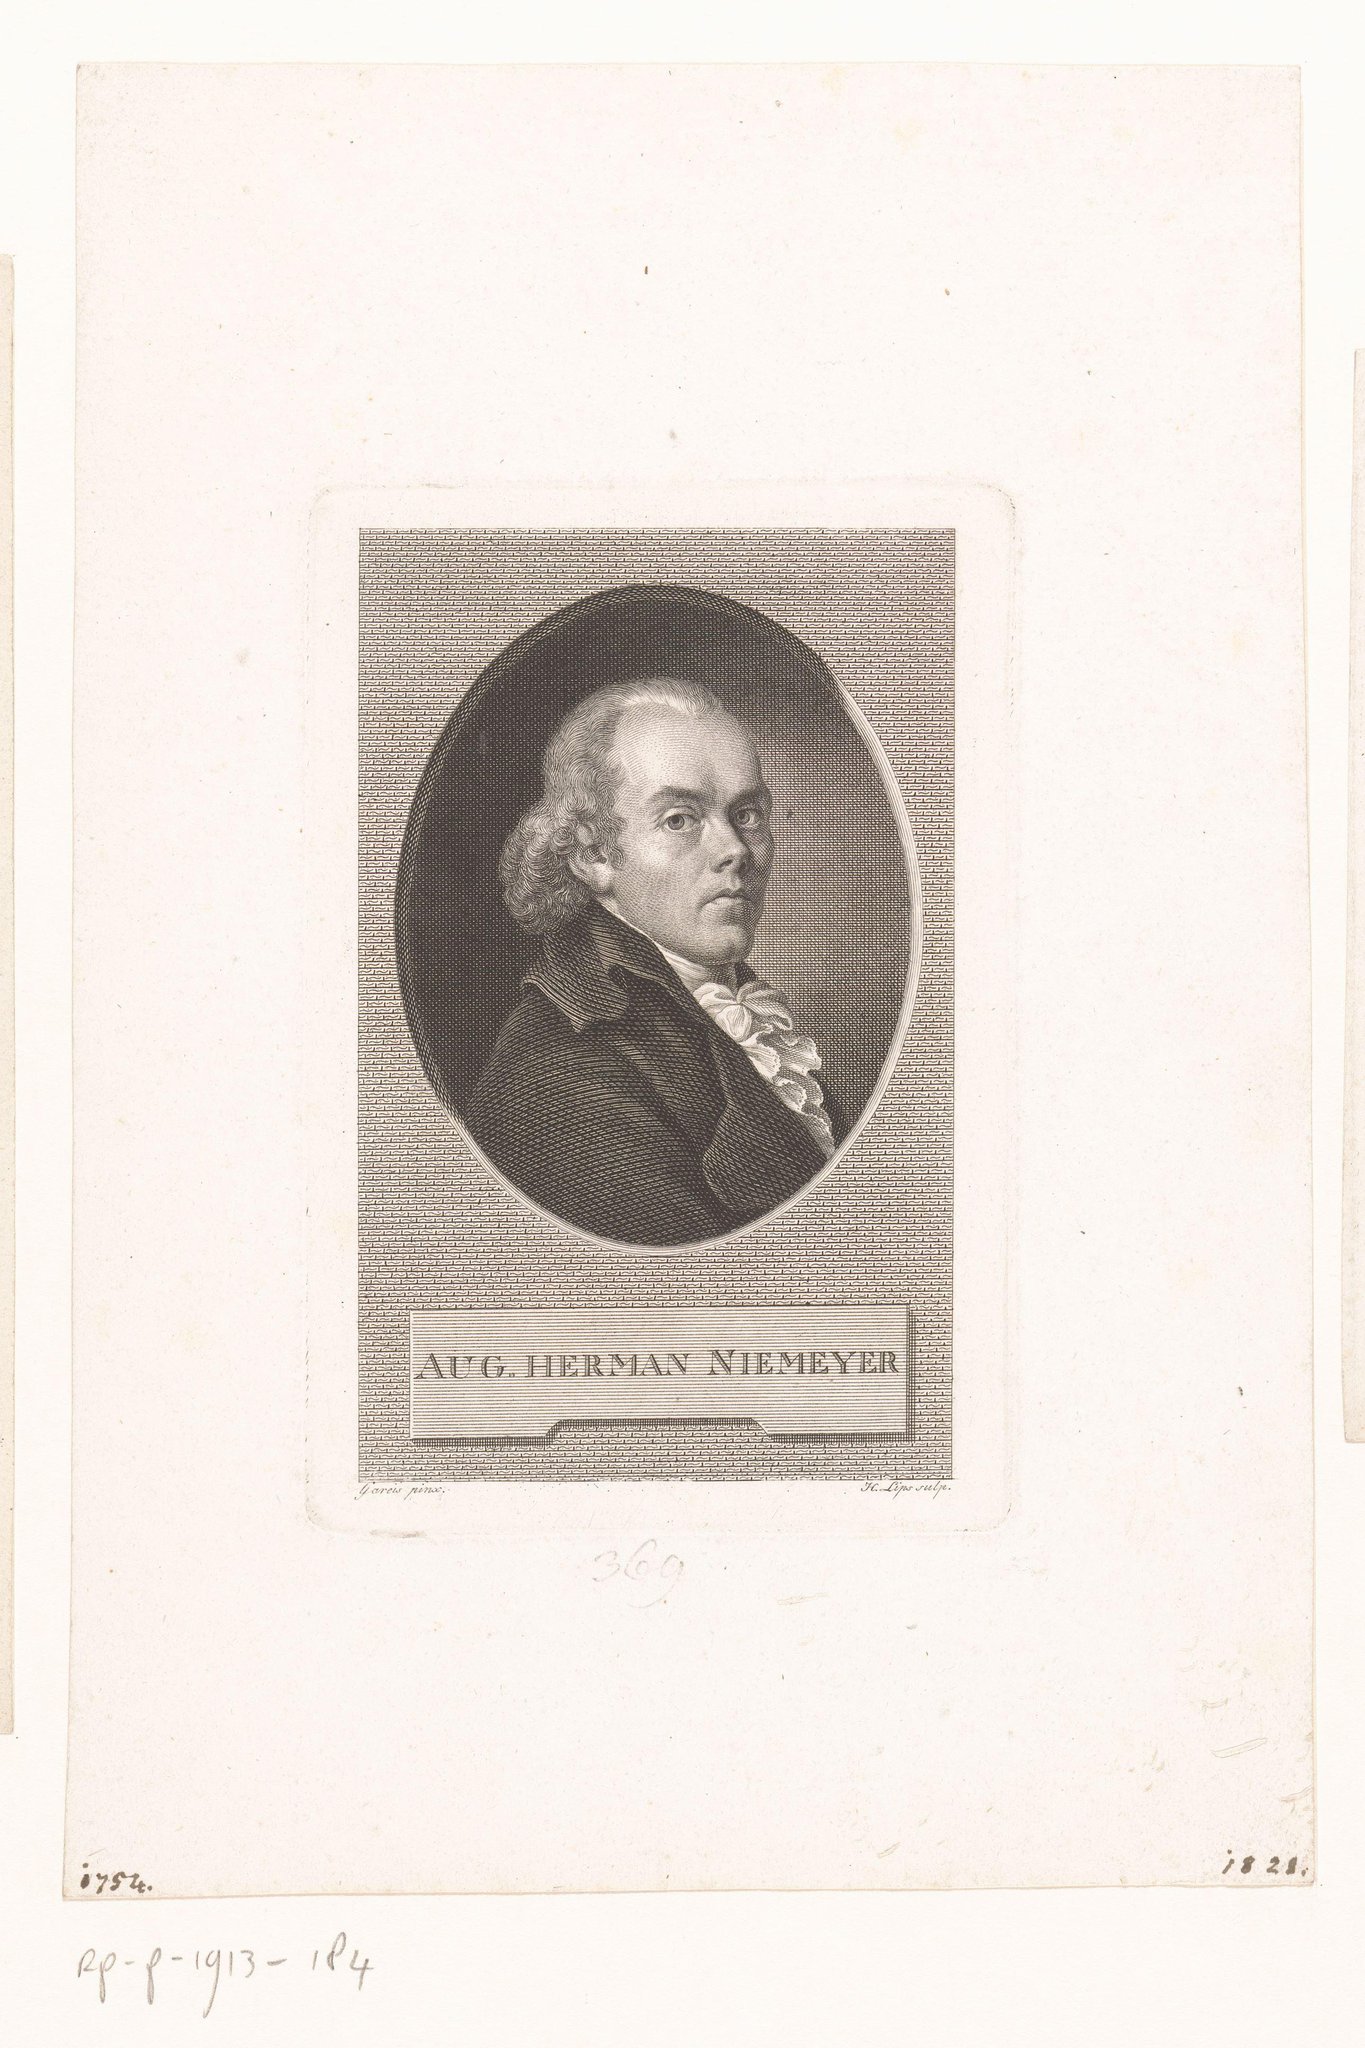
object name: print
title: Portret van August Hermann Niemeyer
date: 1768-1817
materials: paper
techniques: engraving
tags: theologian, historical persons, portrait of a writer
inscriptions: collector's mark: Lugt 2228, date